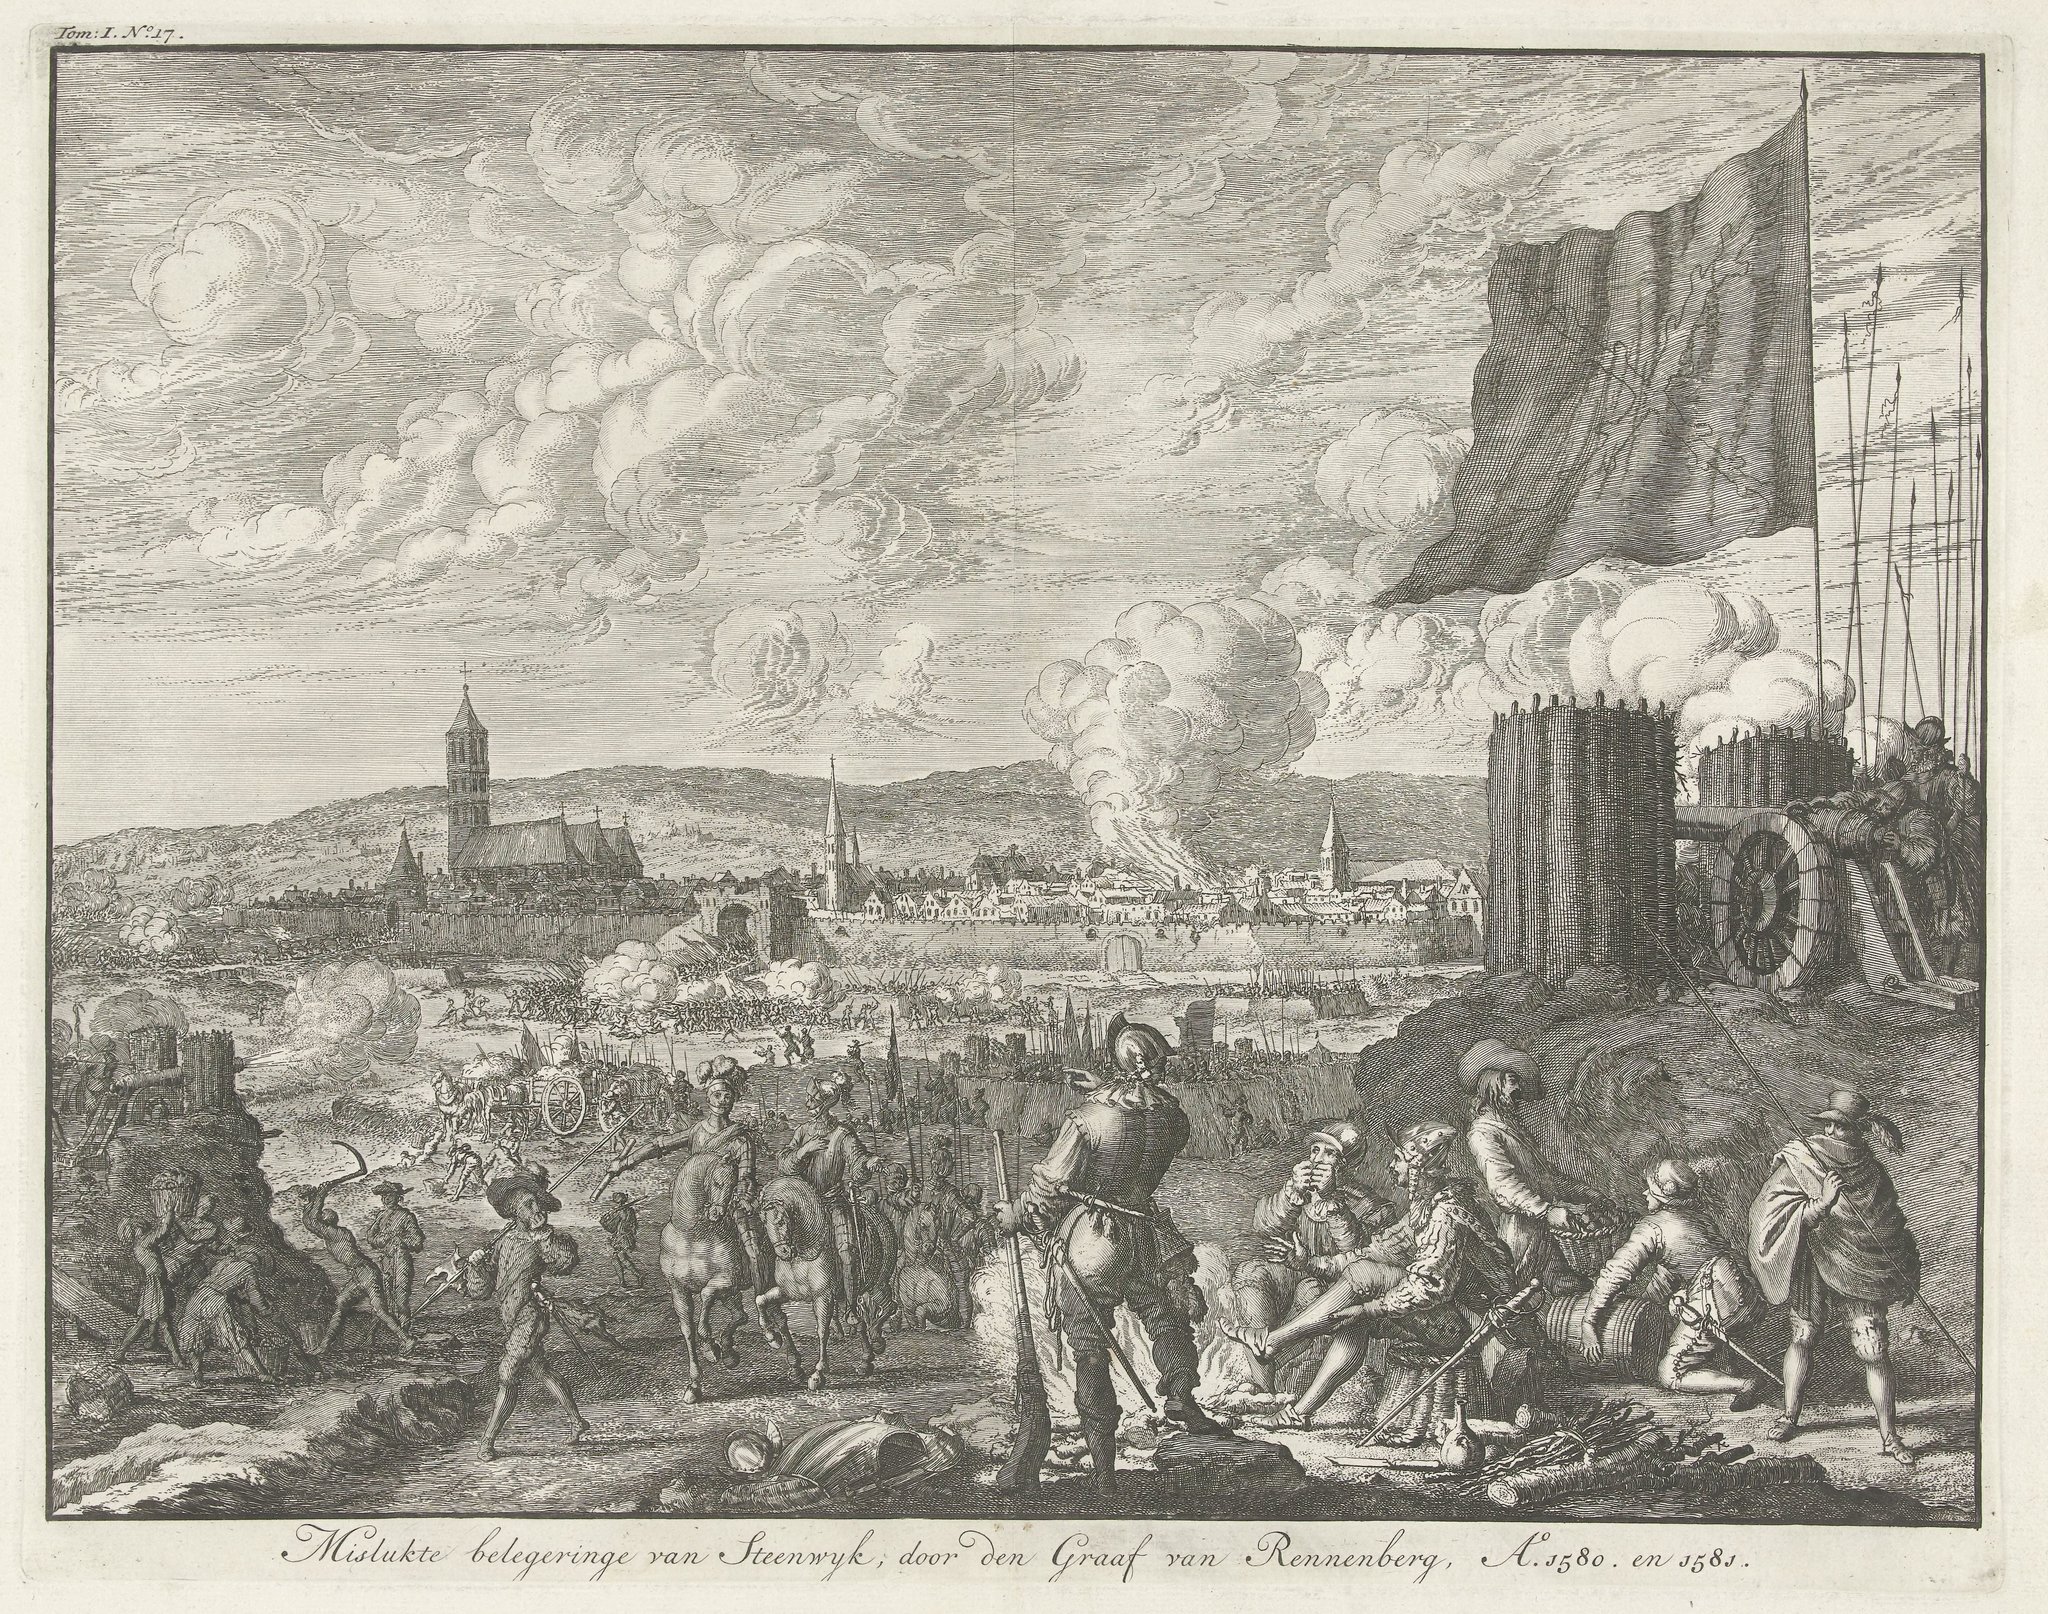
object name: print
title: Mislukte belegeringe van Steenwyk, door den Graaf van Rennenberg, Ao. 1580 en 1581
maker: jan luyken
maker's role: draughtsman, print maker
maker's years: 1649-1712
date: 1678-1680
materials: paper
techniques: etching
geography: northern netherlands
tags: groningen (province), politician, capture of city (after the siege)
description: Gebruikt als illustratie in: J. le Clerc, Geschiedenissen der Vereenigde Nederlanden, sedert den aanvang van die Republyk tot op den Vrede van Utrecht in 't jaar 1713 en het Tractaat van Barriere in 't jaar 1715 gesloten, Z. Chatelain, Amsterdam 1730, 3 delen, dl. I.